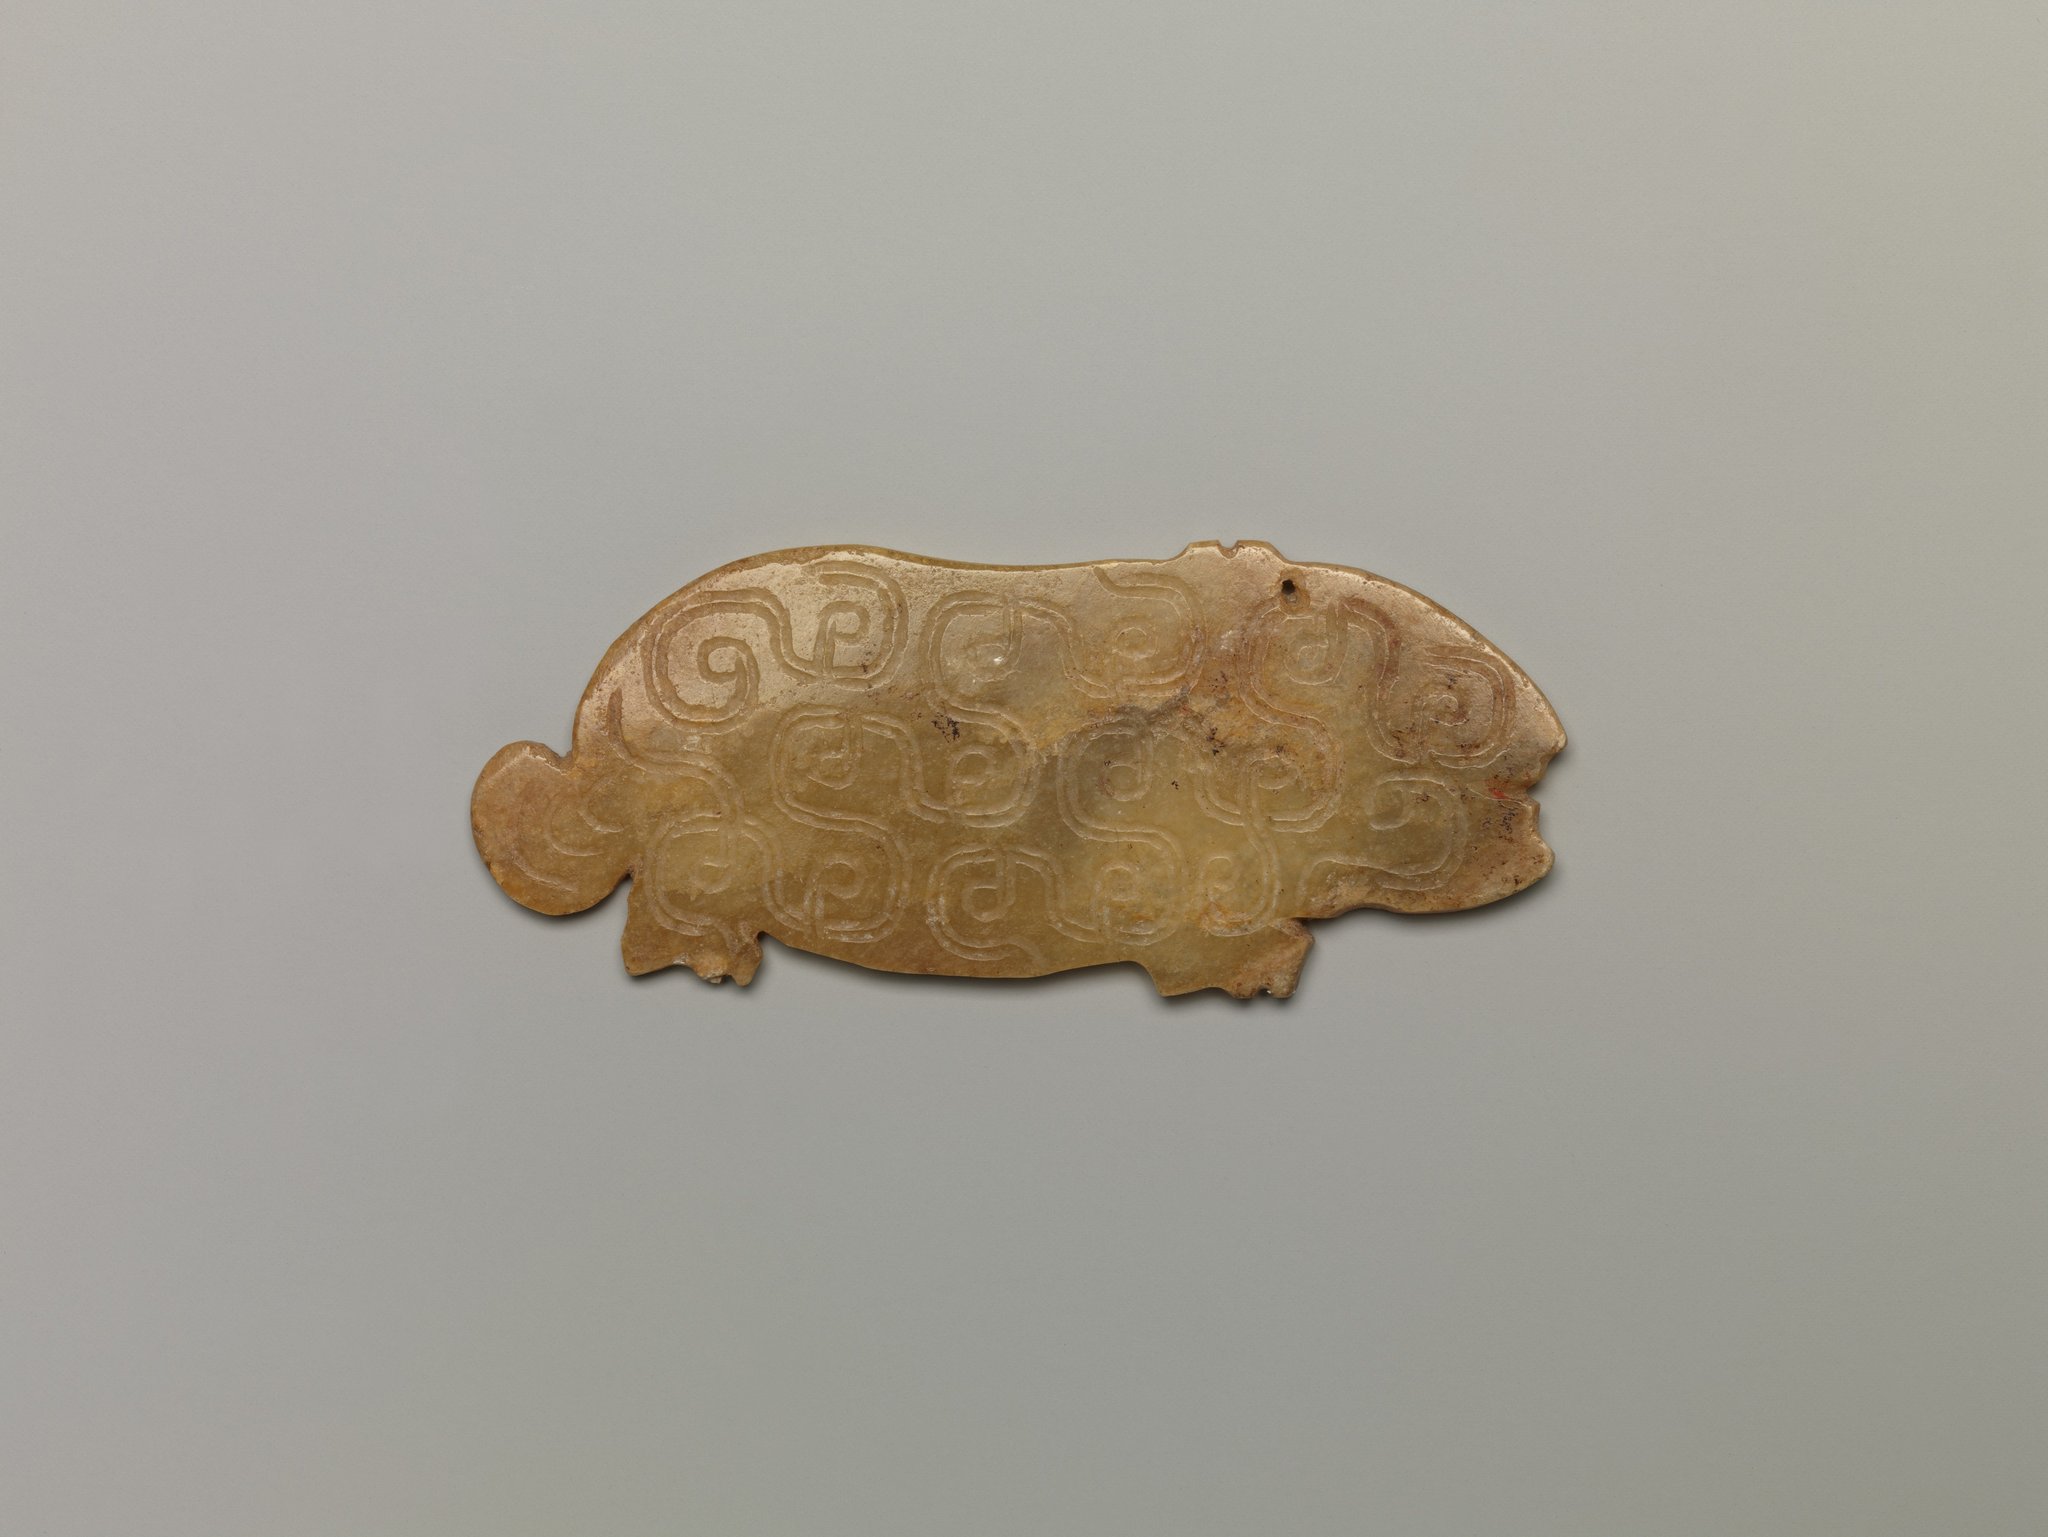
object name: plaque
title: Plaque in the shape of an animal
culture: chinese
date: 500-401 BCE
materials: jade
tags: animals